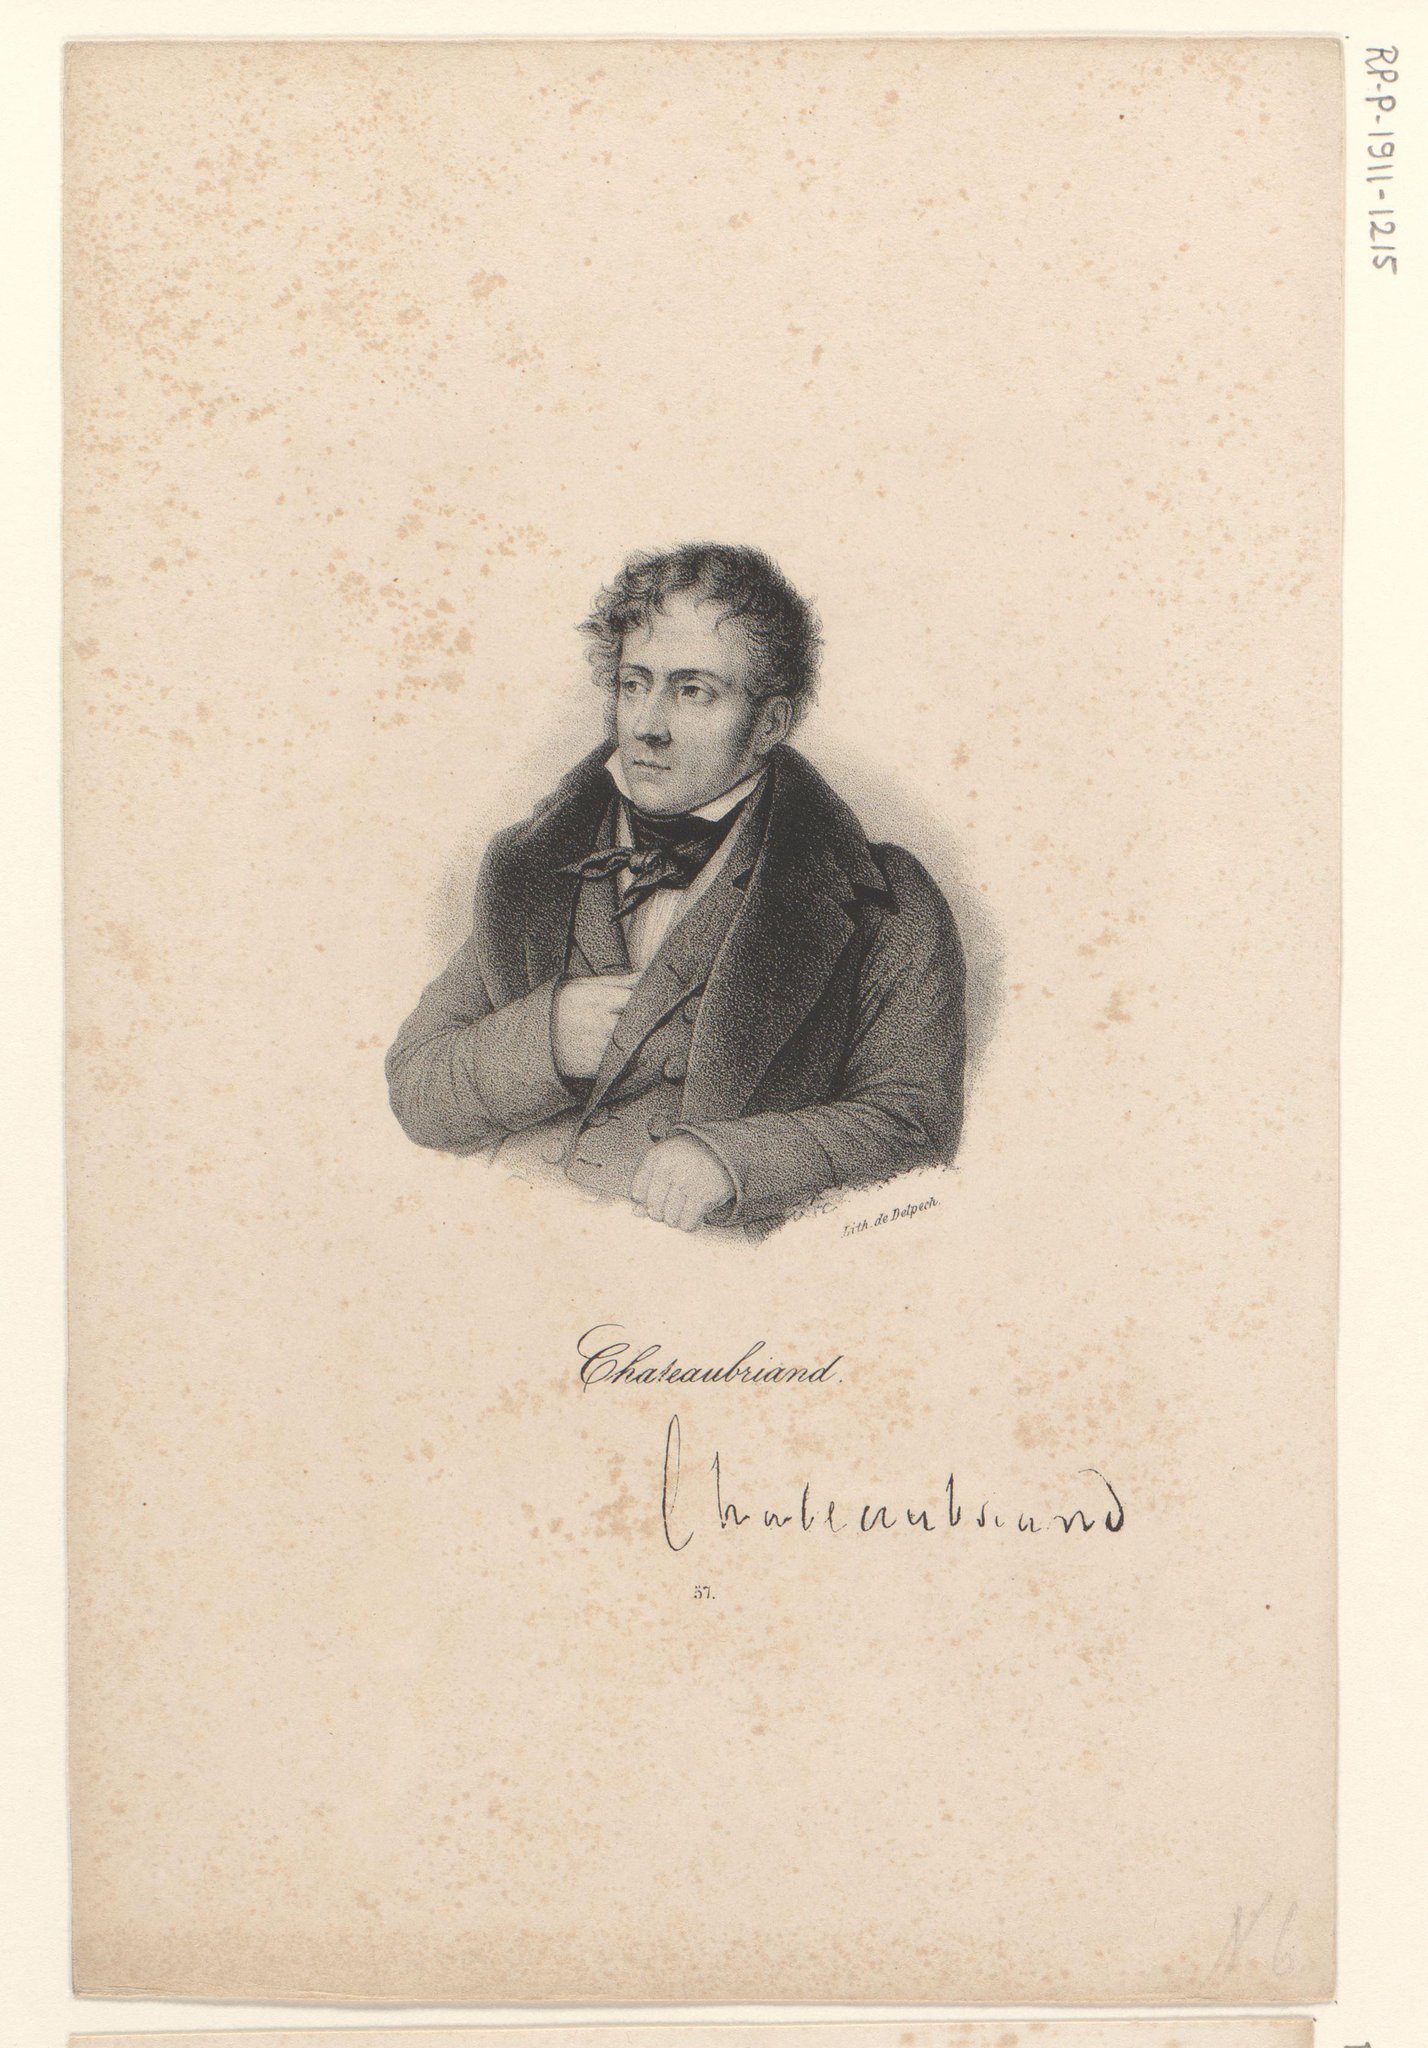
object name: print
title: Portret van François-René de Chateaubriand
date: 1818-1842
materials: paper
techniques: lithograph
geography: paris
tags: paris, politician, françois-rené de chateaubriand, historical persons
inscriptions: collector's mark: Lugt 2228a